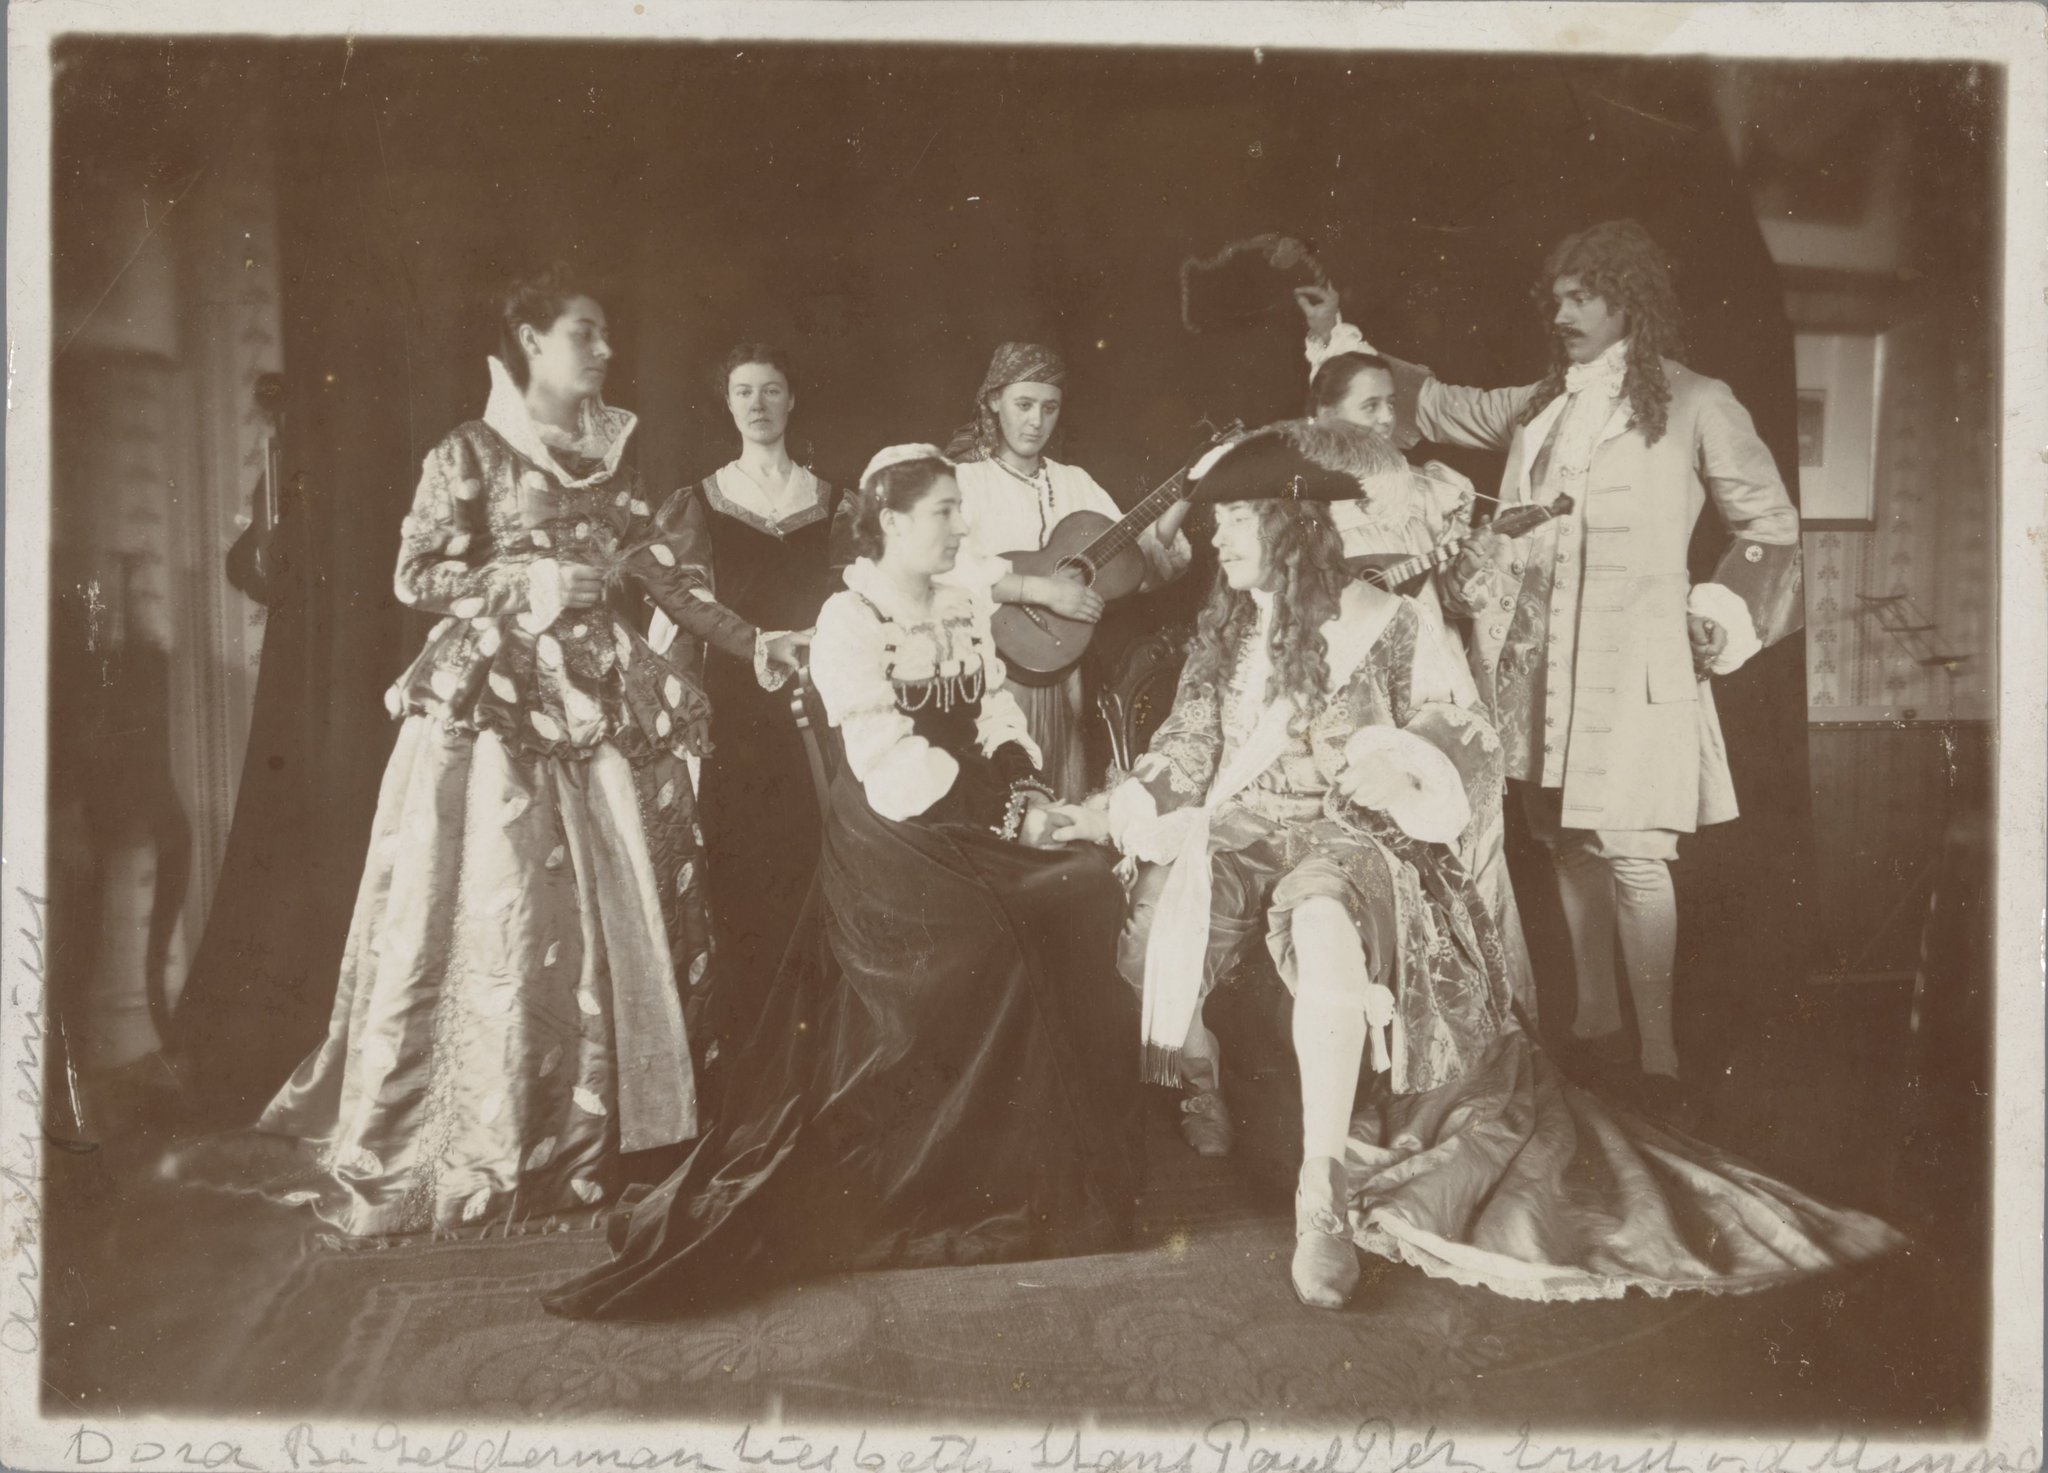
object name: photograph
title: Dora, Be Zelderman, Liesbeth, drieling Arntzenius en Ernst v/d Minne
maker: willem witsen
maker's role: draughtsman, painter, print maker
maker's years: 1860-1923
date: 1860-1915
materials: cardboard, paper, photographic support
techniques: gelatin silver print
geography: amsterdam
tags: the hague, ernst van der minne